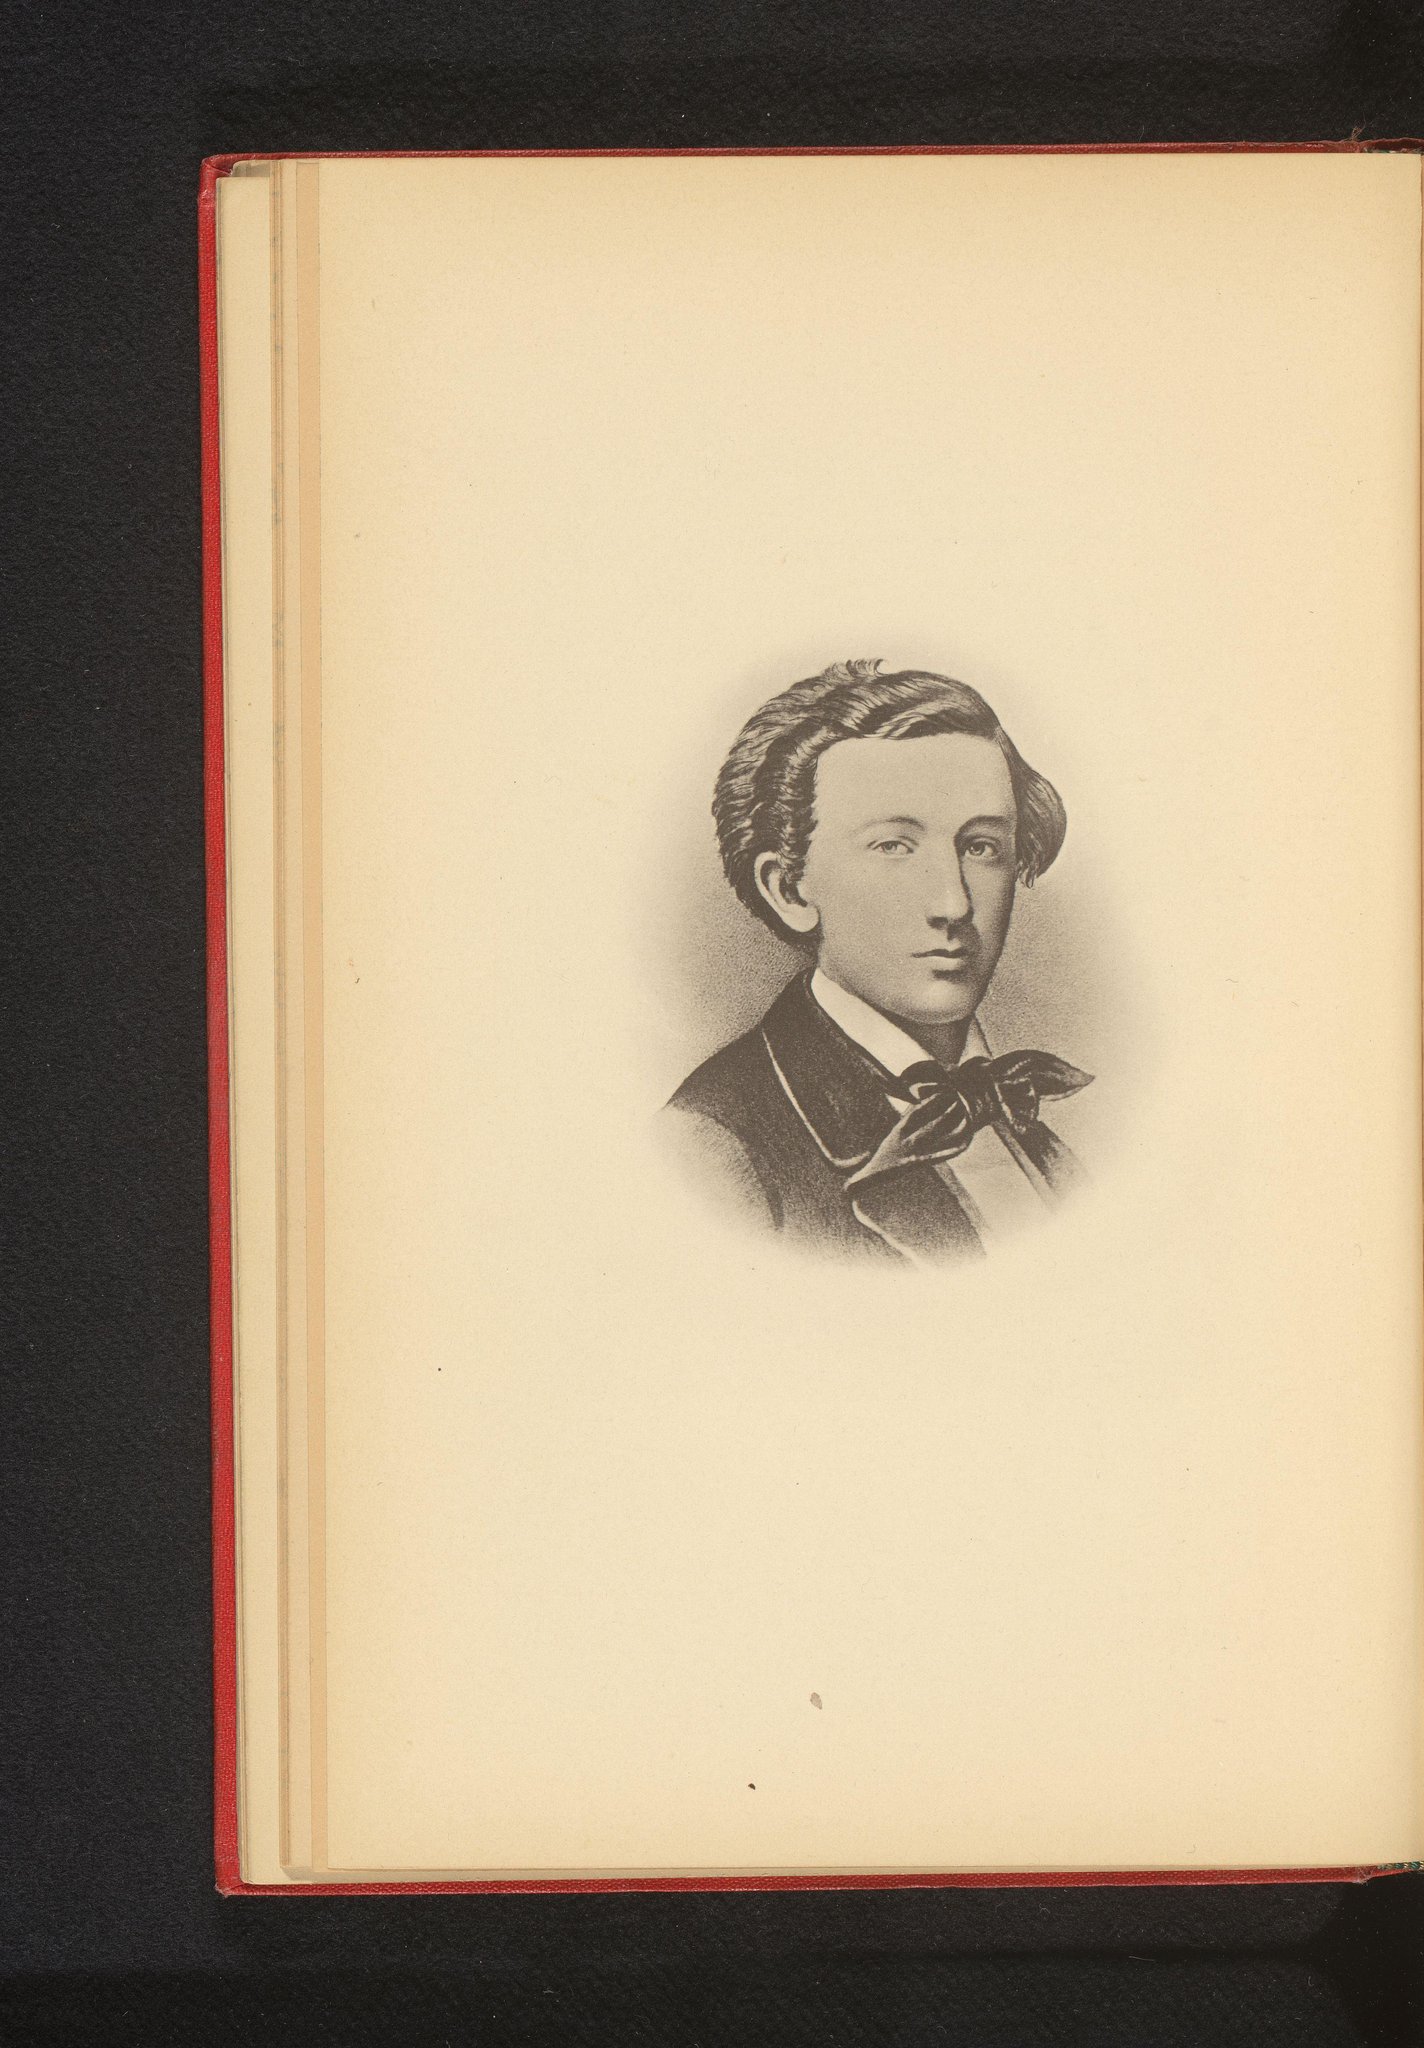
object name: page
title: Fotoreproductie van een schilderij, voorstellende een portret van Gustaf Werner Holmberg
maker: Anonymous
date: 1873-1883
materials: paper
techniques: photograph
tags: portrait, self-portrait of painter